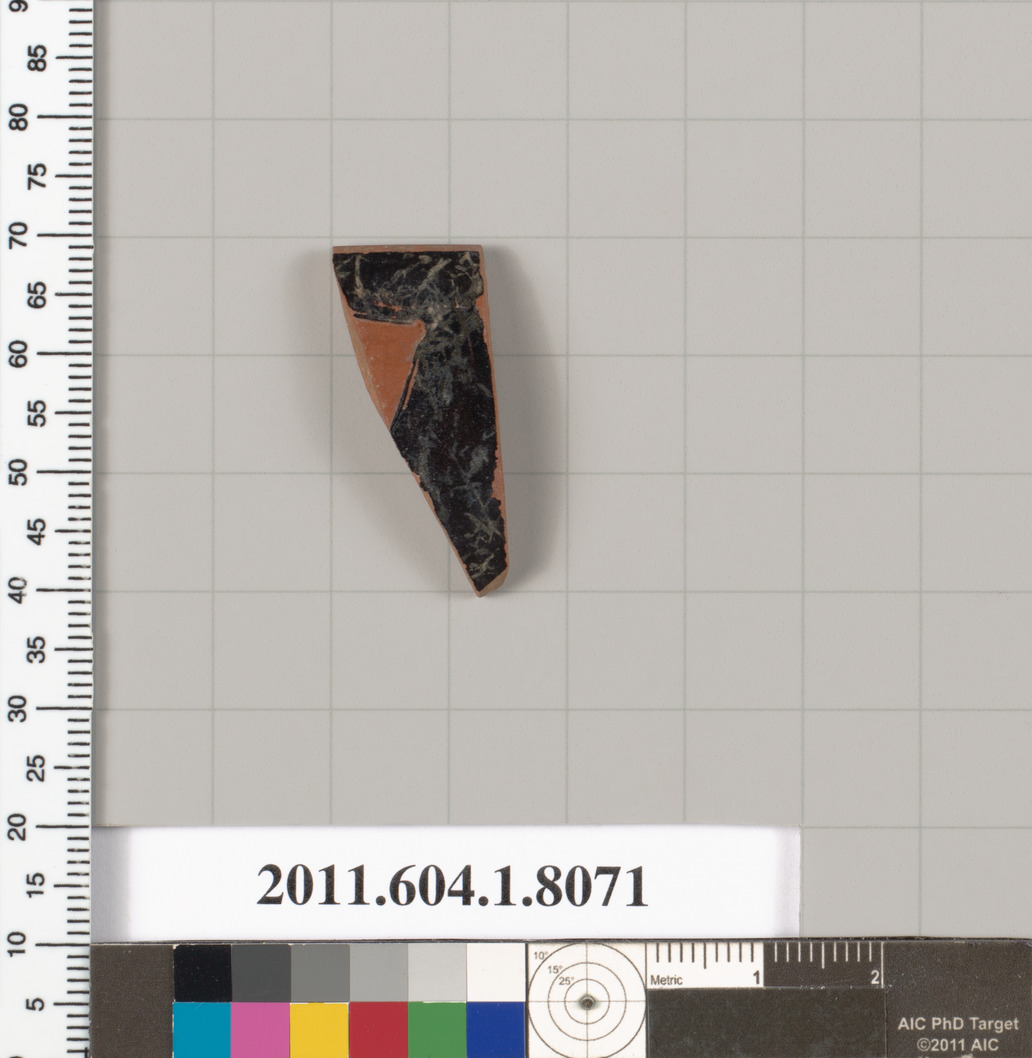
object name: kylix fragment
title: Terracotta rim fragment of a kylix (drinking cup)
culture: greek, attic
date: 510-500 BCE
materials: terracotta